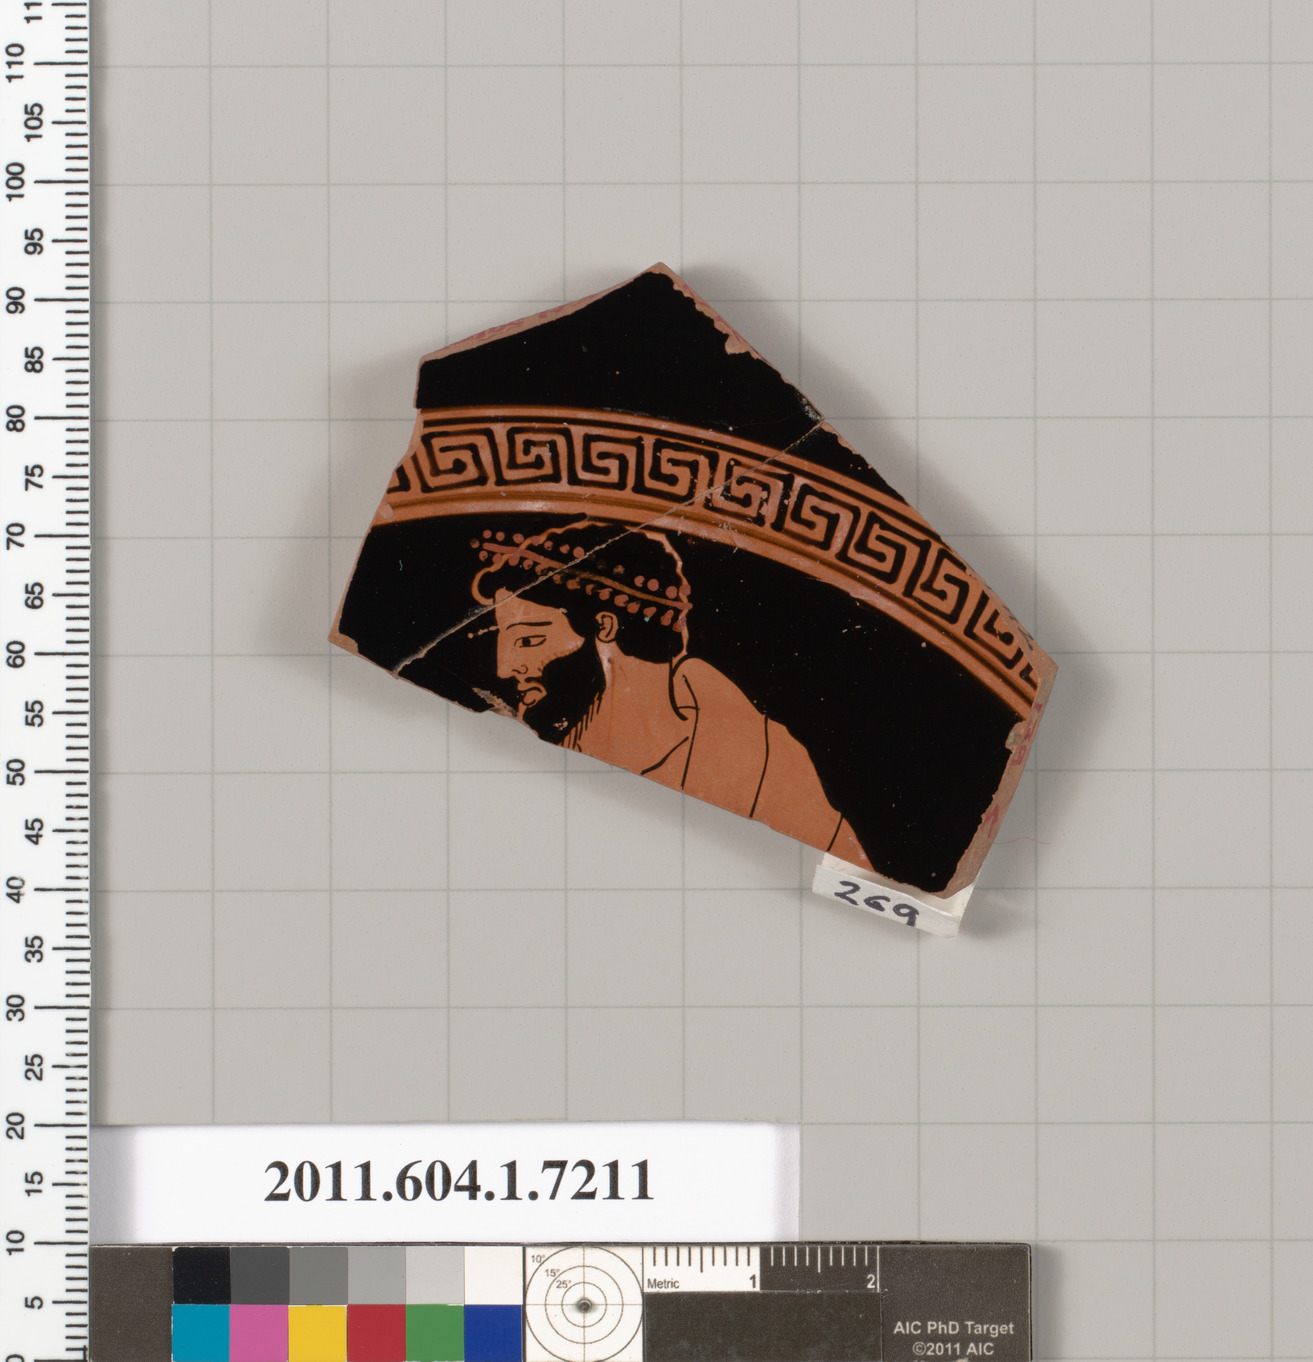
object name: kylix fragment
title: Terracotta fragment of a kylix (drinking cup)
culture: greek, attic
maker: makron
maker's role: artist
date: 500-480 BCE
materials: terracotta